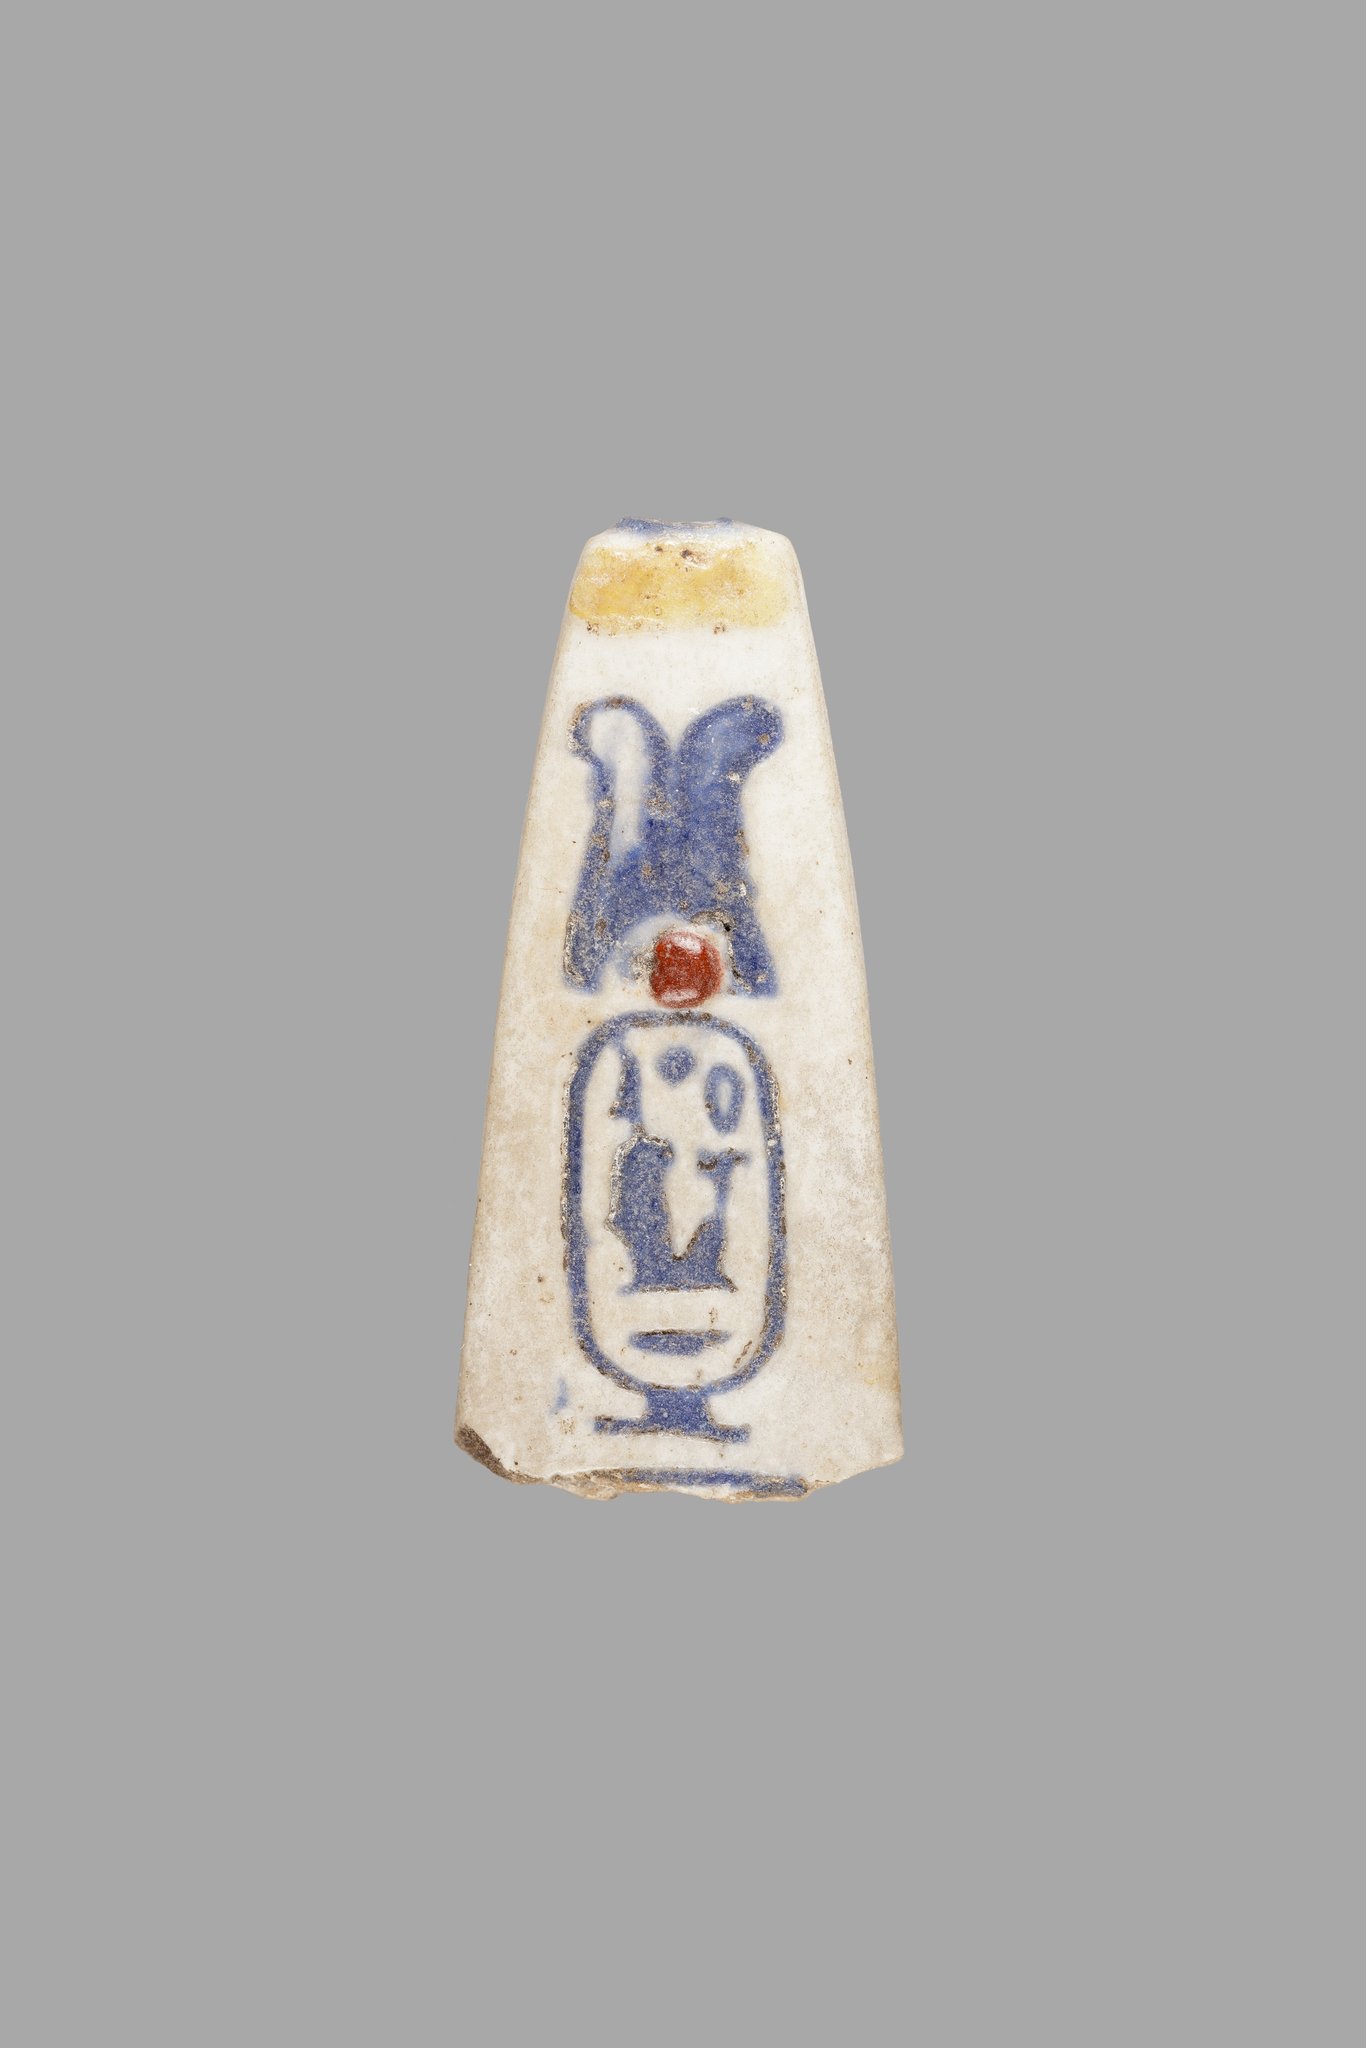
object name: bead, lotus petal, amenhotep iii, nebmaatre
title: Lotus Petal Bead Inscribed with the Throne Name of Amenhotep III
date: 1390-1352 BCE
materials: faience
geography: egypt